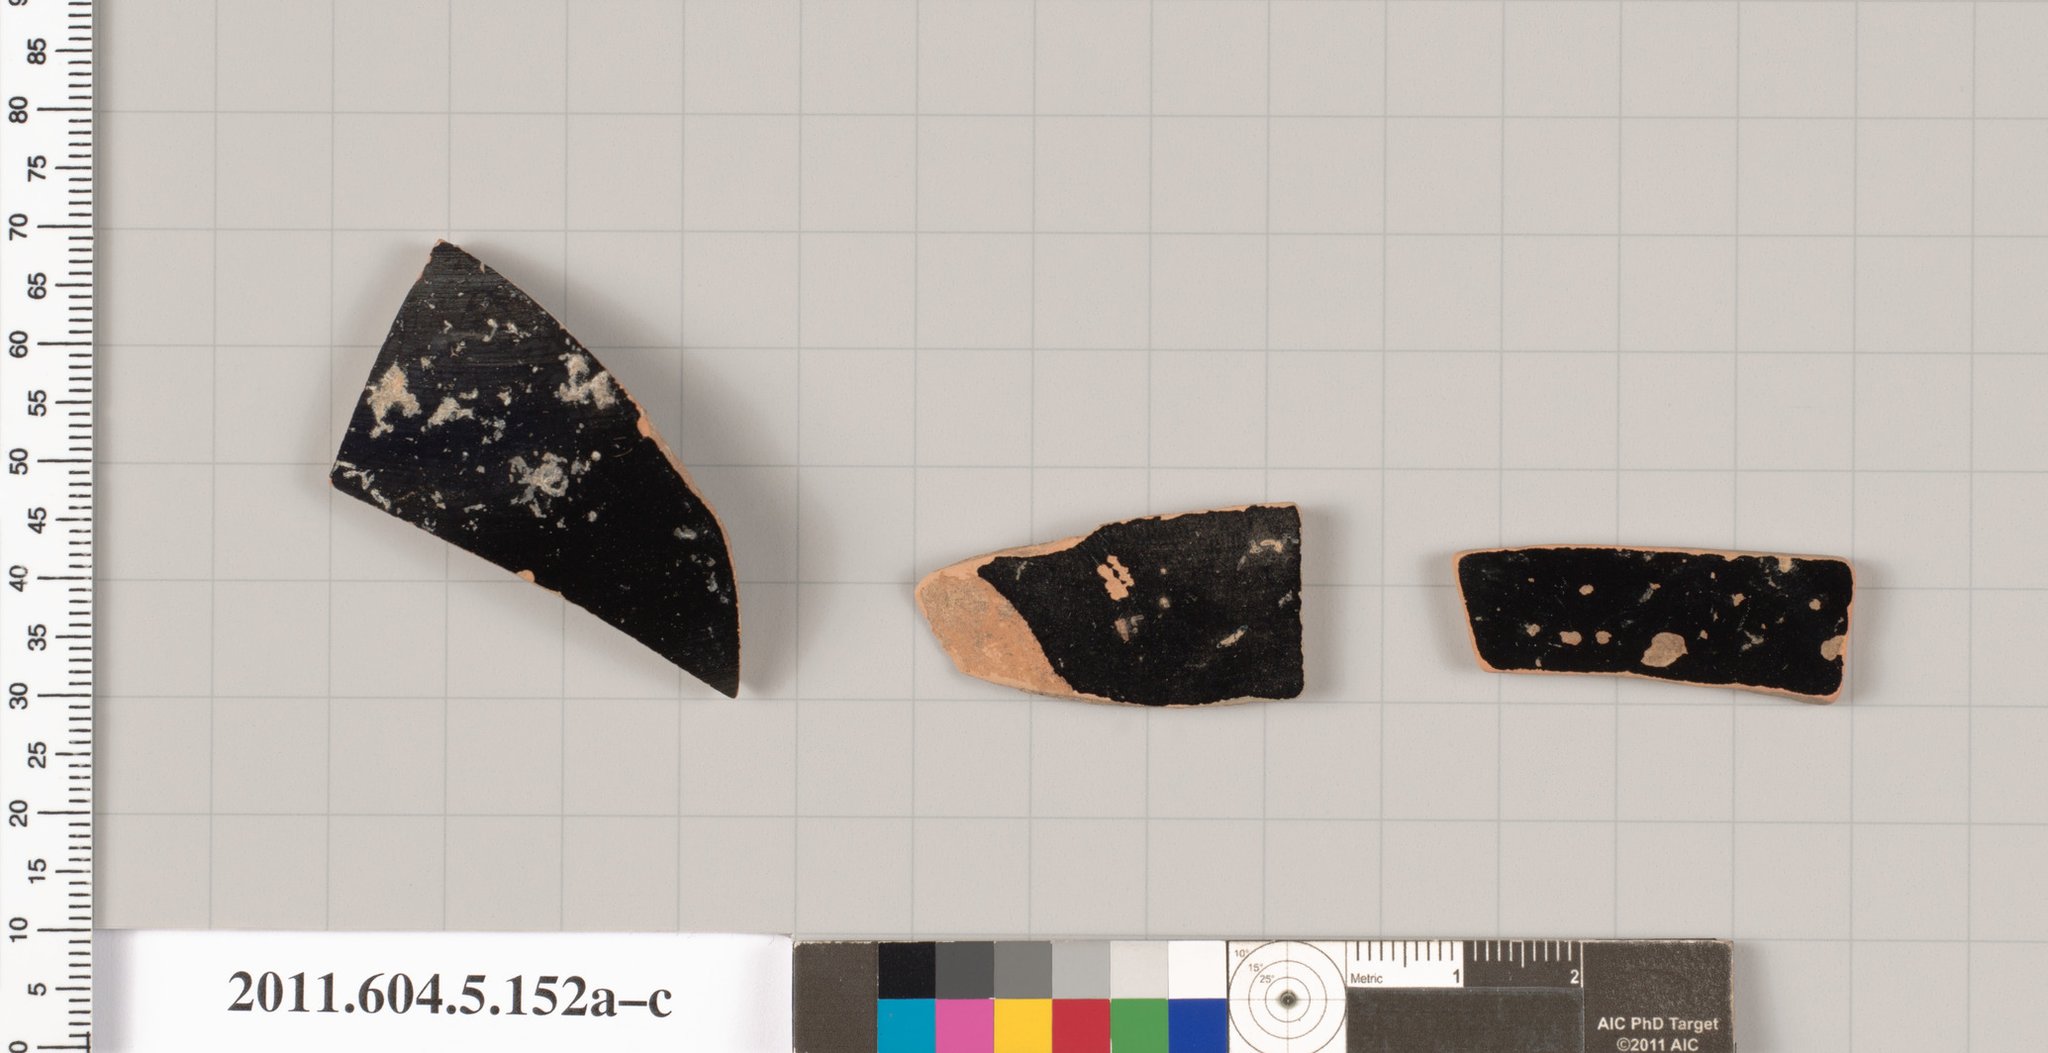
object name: kylix fragment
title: Terracotta fragments of kylikes (drinking cups)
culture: greek, attic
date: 600-401 BCE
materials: terracotta